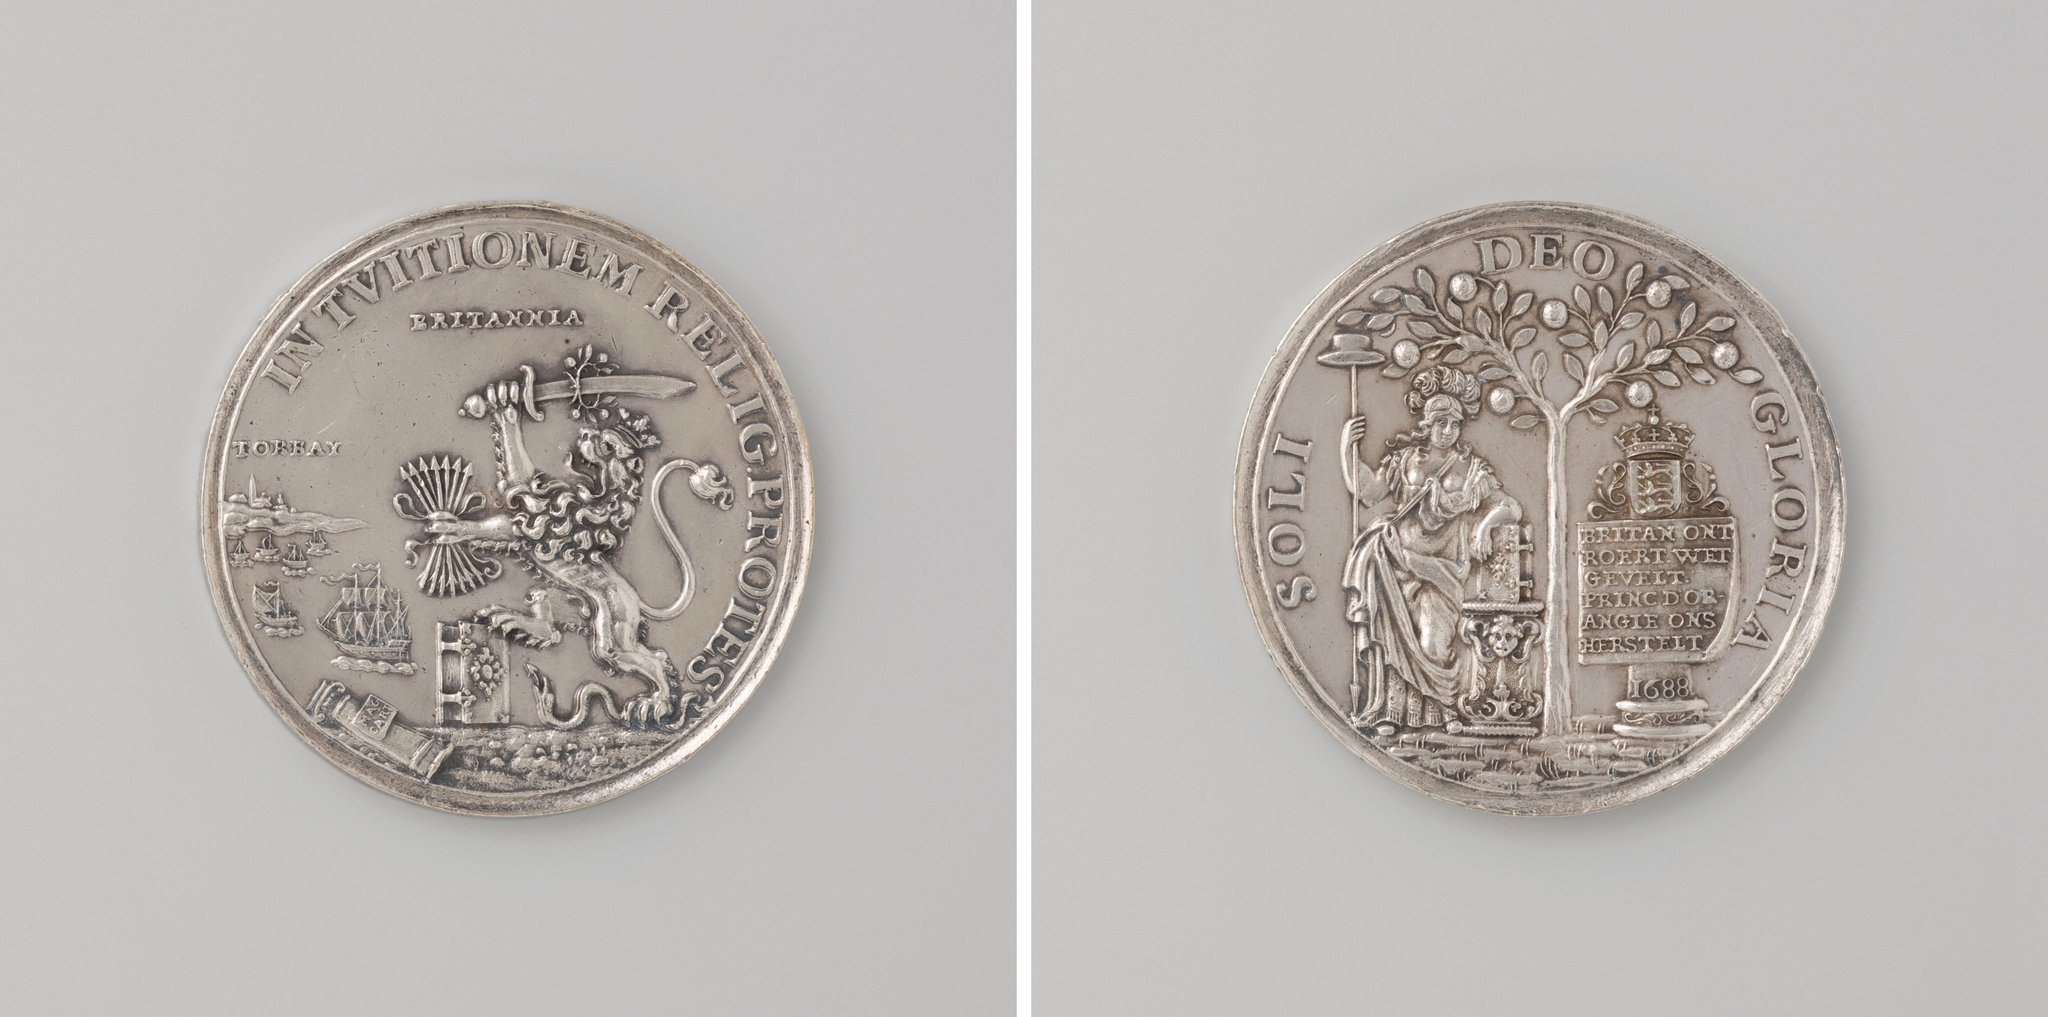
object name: history medal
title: Landing van Willem III bij Torbay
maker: Anonymous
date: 1688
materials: silver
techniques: striking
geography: netherlands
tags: the hague, william iii (prince of orange and king of england, scotland, and ireland), england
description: Zilveren penning. Voorzijde: Britannia met vrijheidshoed op lans en rustend op bijbel op altaar staat onder oranjeboom, rechts pilaar met gekroond wapenschild van Engeland en opschrift binnen omschrift. Keerzijde: leeuw met omkranst zwaard en pijlenbundel vertrapt met ene klauw slang en rust met andere op bijbel, op achtergrond landing binnen omschrift.